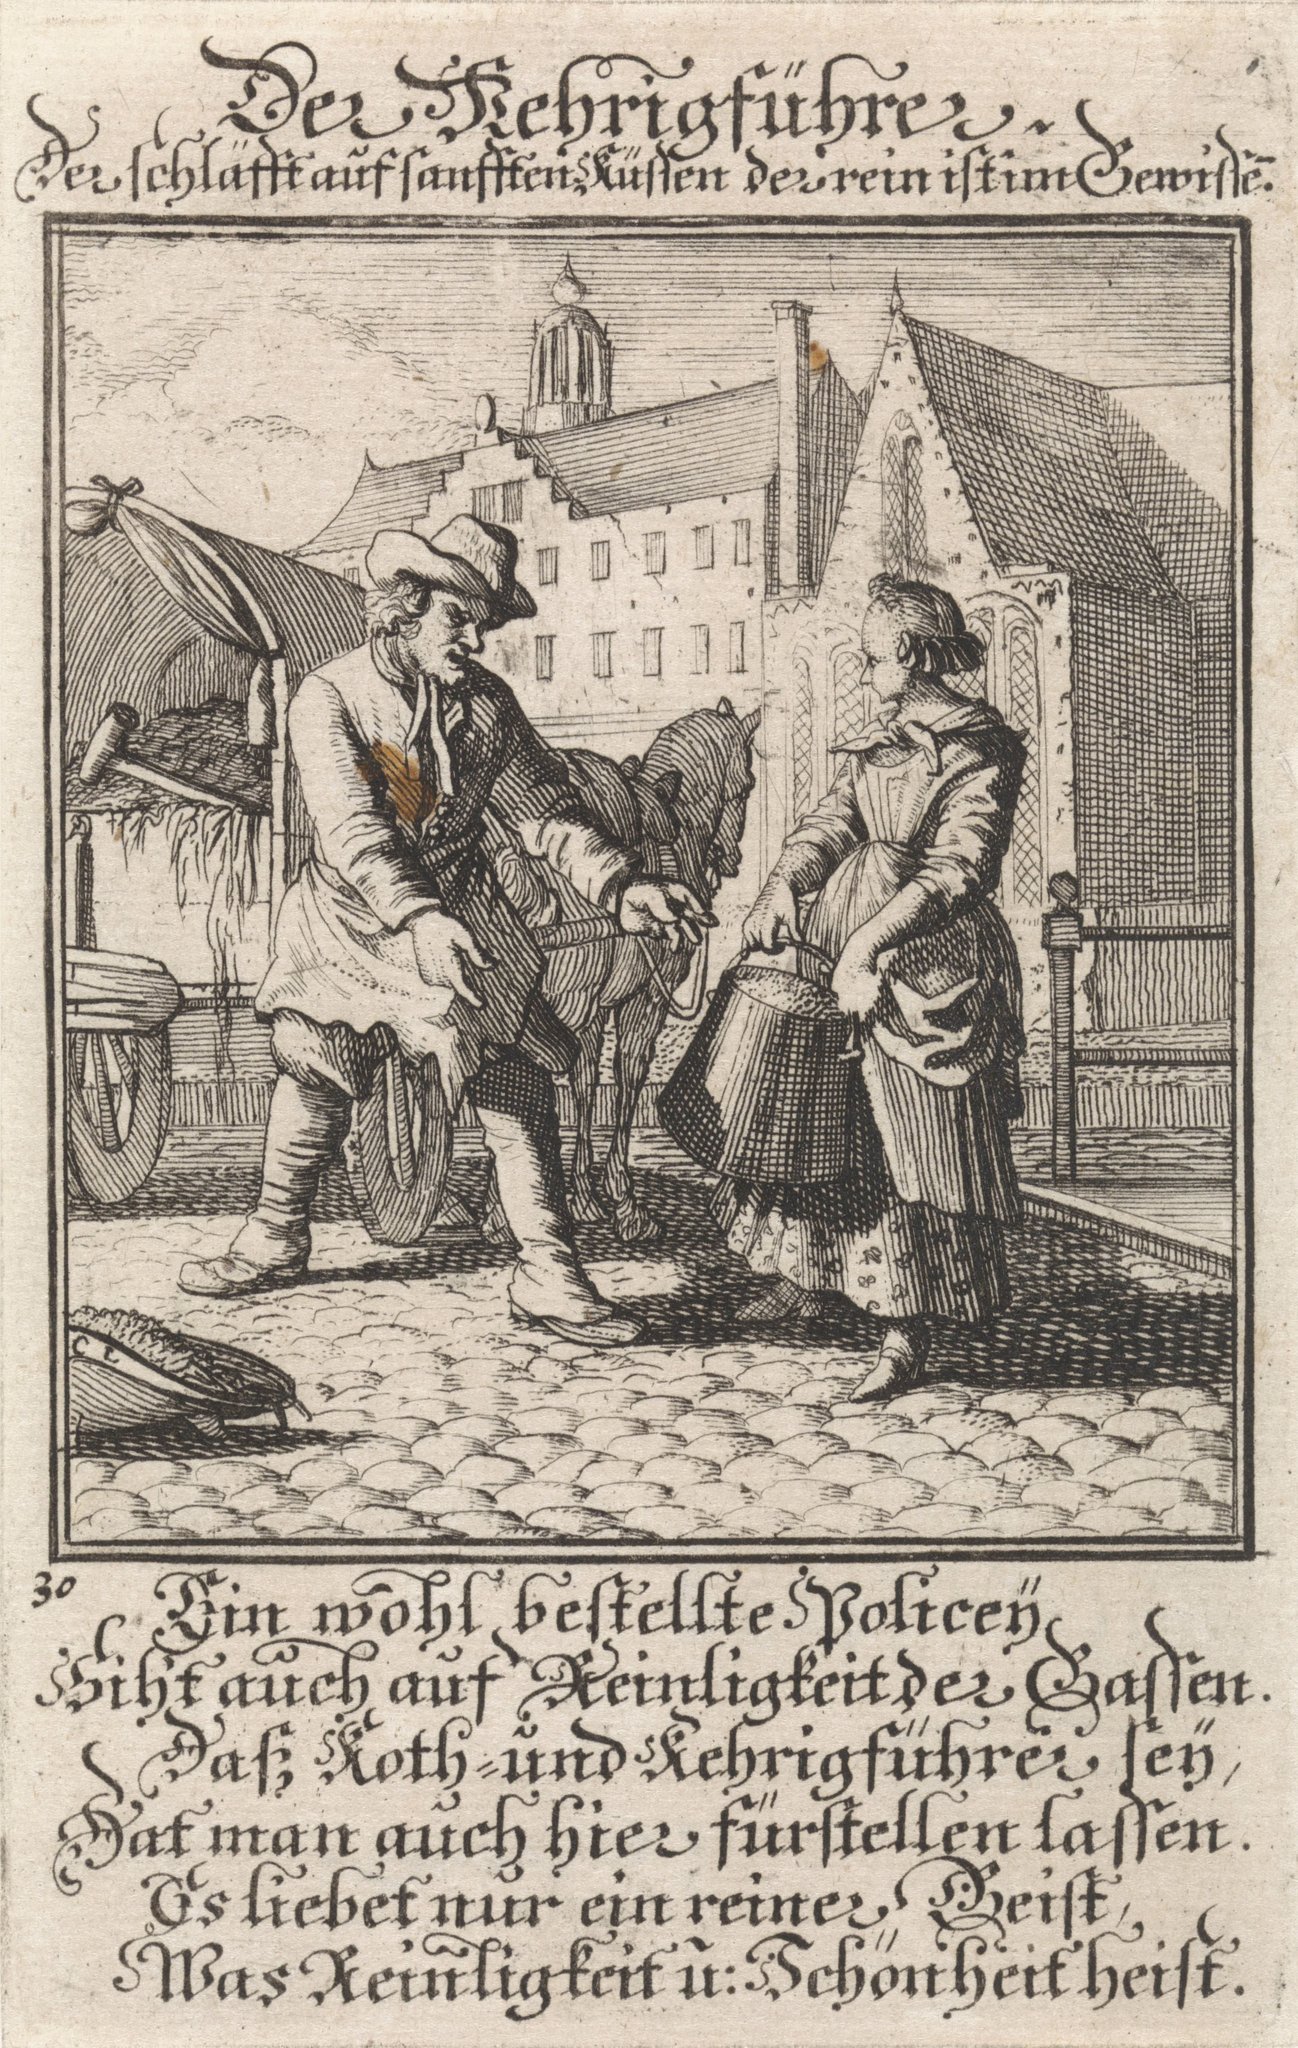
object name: book illustration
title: Der Kehrigführer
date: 1711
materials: paper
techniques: etching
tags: ash, garbage collection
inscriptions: collector's mark: Lugt 2228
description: Illustratie uit: Sancta Clara, Abraham à. Etwas für Alle, das ist: Eine kurtze Beschreibung allerley Stands- Ambts- und Gewerbs-Persohnen (...), 3 delen (1699-1733). Würtzburg: Martin Frantz Hertz, 1711, dl. III, p. 286. Het betreft hier de tweede druk van deel III.